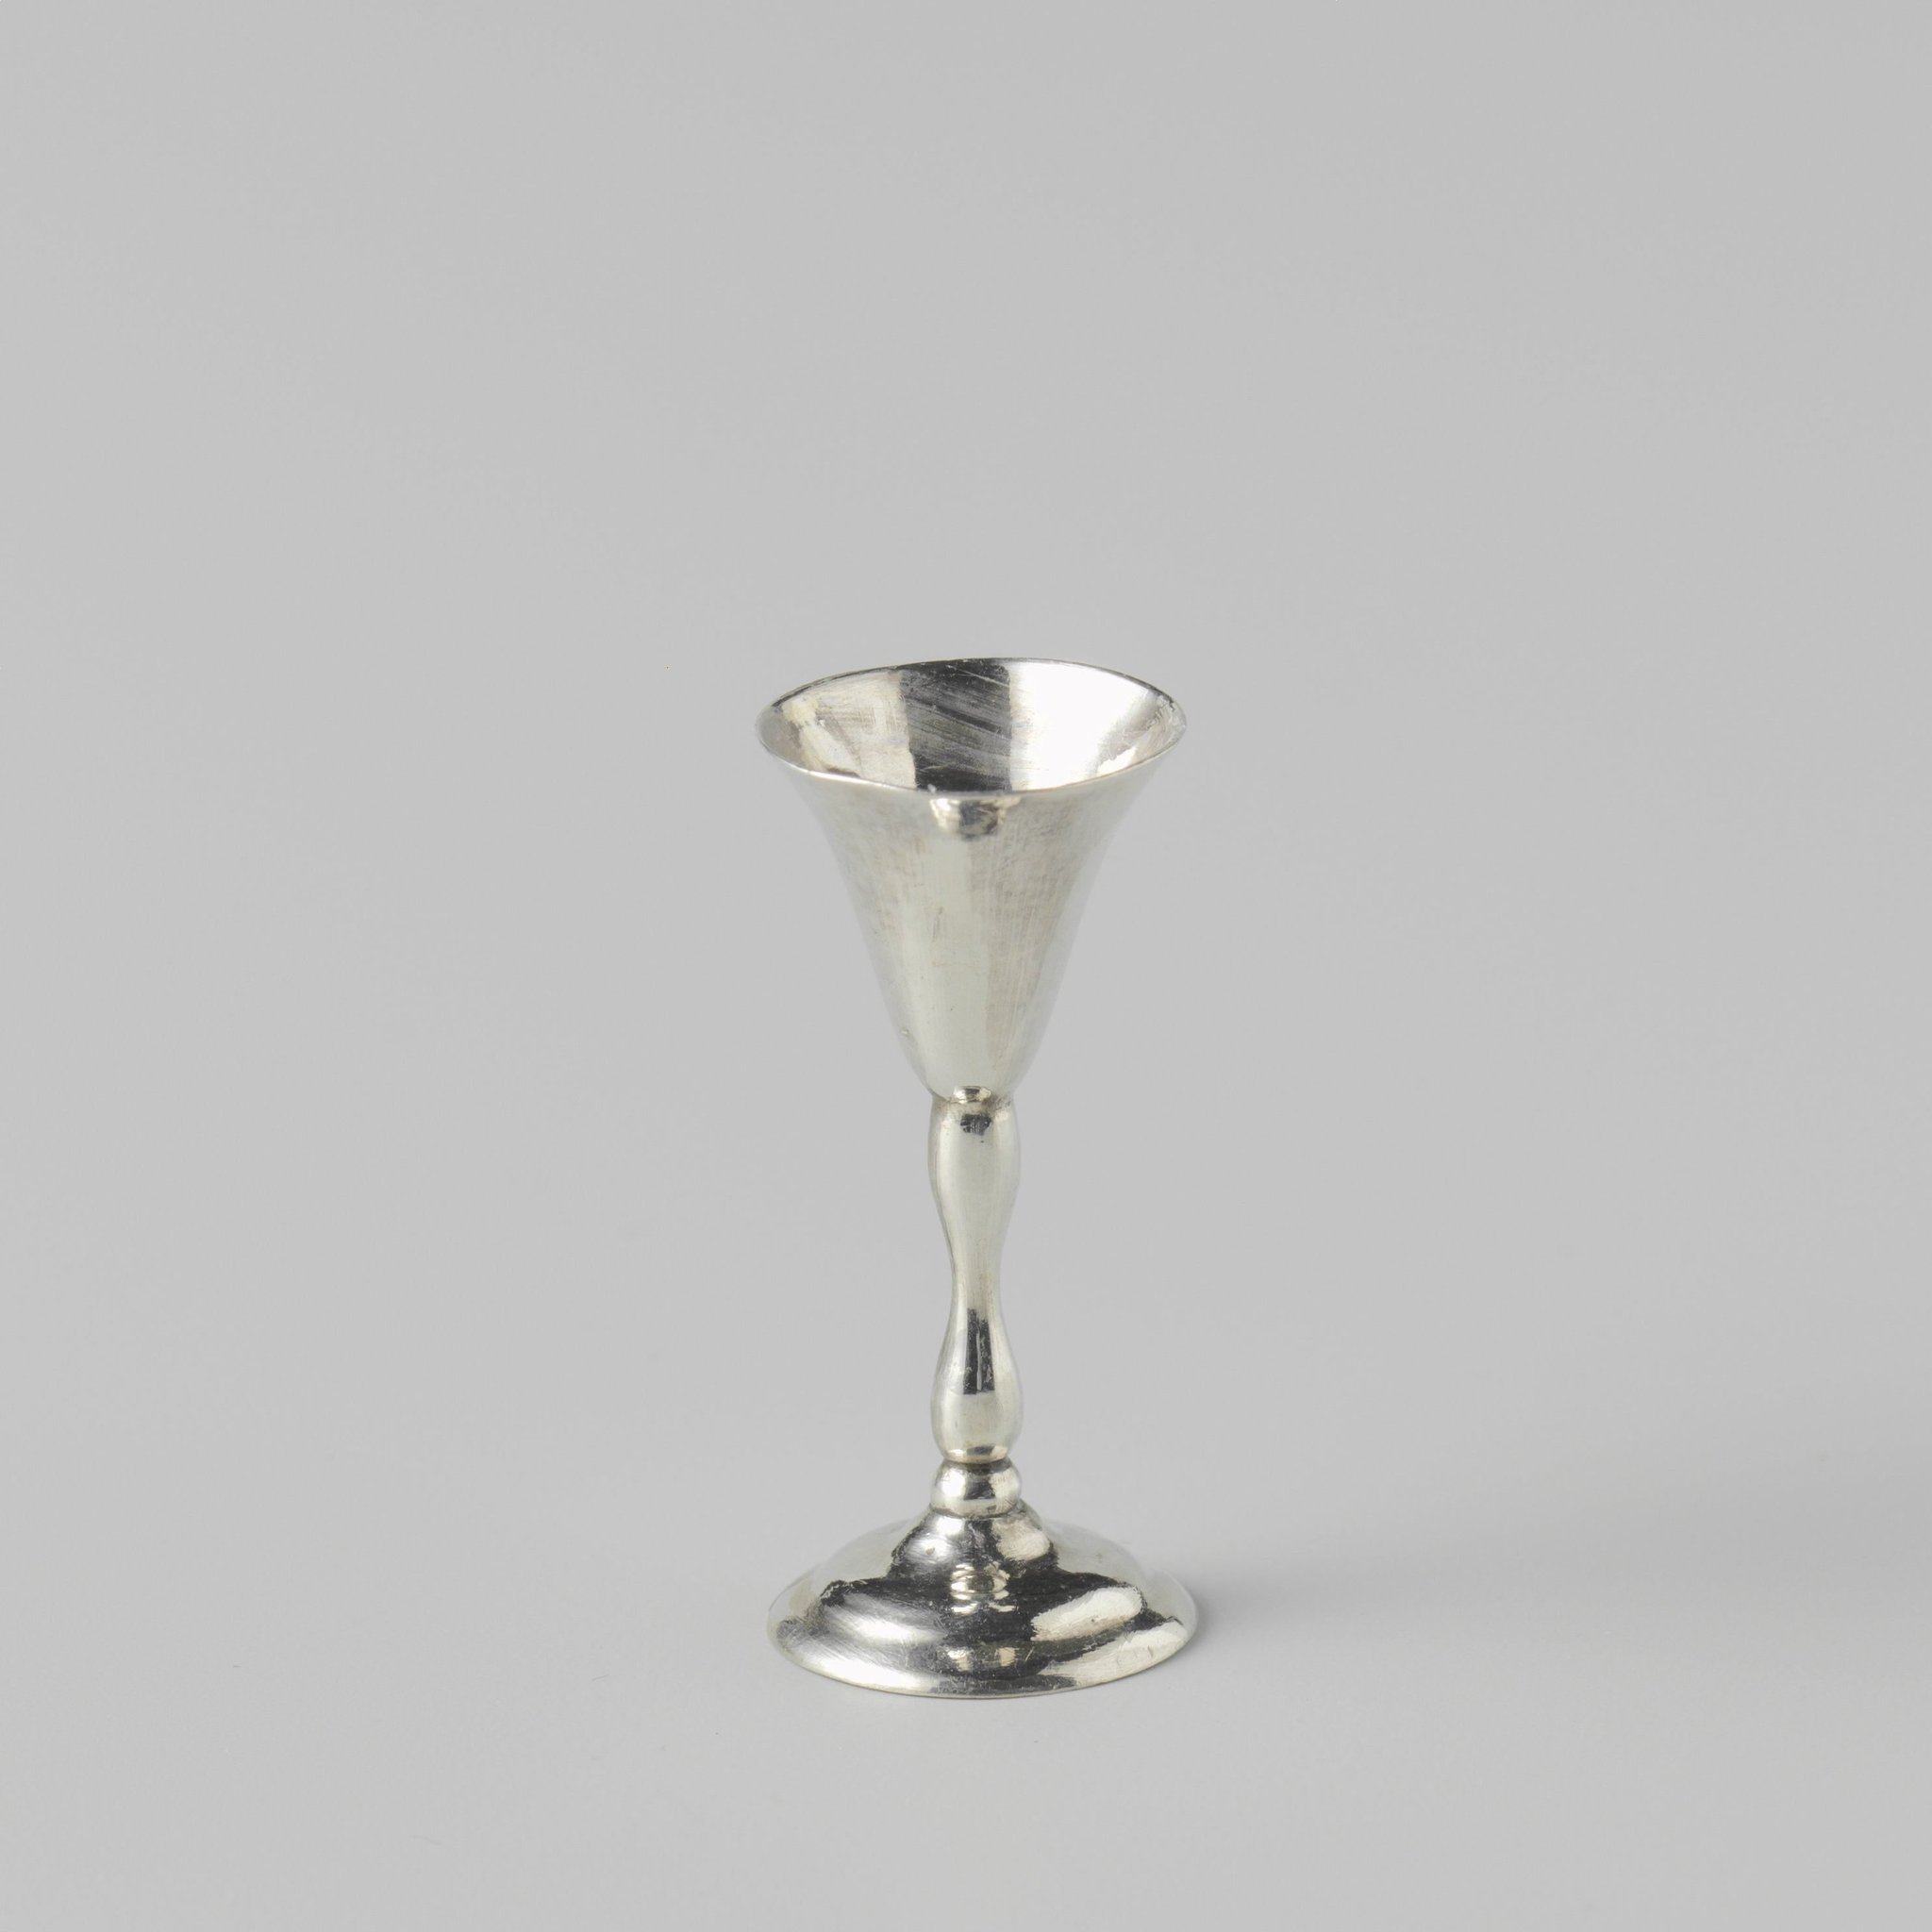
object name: miniature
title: Drinkglas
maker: Anonymous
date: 1725-1775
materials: silver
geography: netherlands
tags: glass, rummer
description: Trechtervormig drinkglas op een hoge balustervormige stam. De voet is rond en gewelfd. Het drinkglas is gelijk aan vijf andere exemplaren (BK-NM-11177-181-b-III, BK-NM-11177-181-b-IV, BK-NM-11177-181-b-VI, BK-NM-11177-181-b-VII, BK-NM-11177-181-VIII). De drinkglazen staan met een schenkkan (BK-NM-11177-181-b-VII) op een dienblad (BK-NM-11177-181-b-VIII). Het dienblad staat op een klaptafel (BK-NM-11177-a).